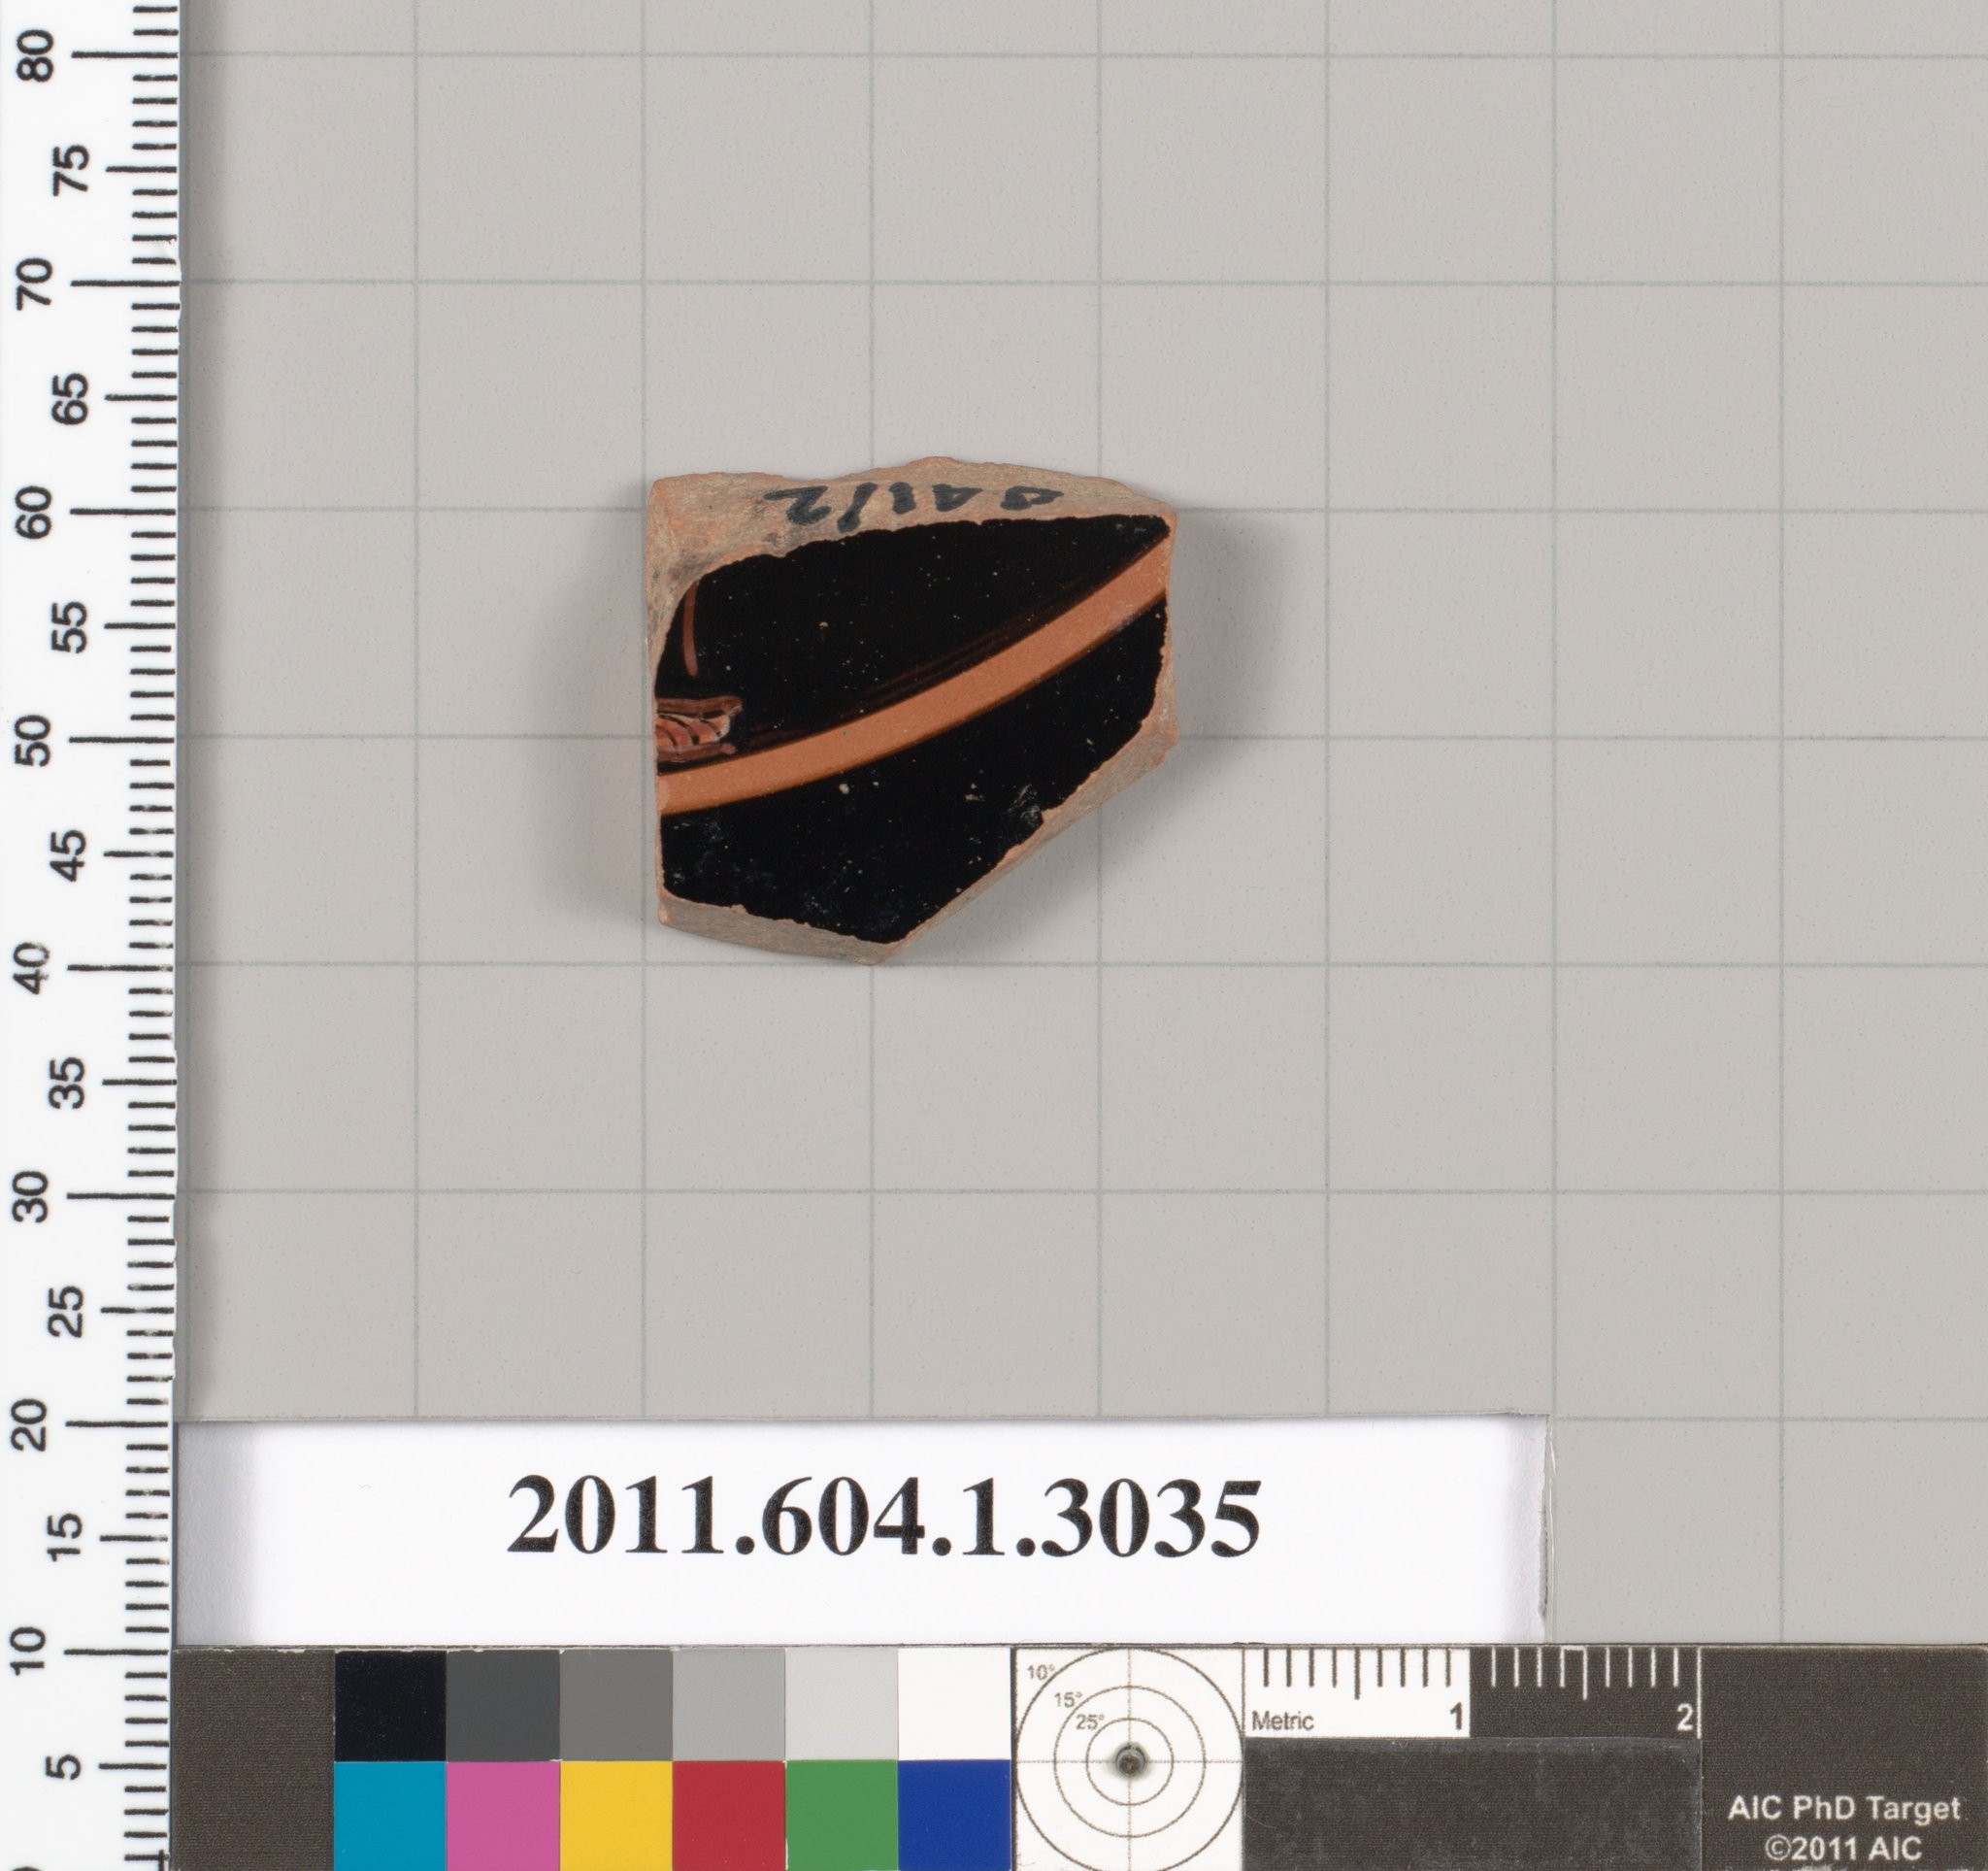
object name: kylix fragment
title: Terracotta fragment of a kylix (drinking cup)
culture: greek, attic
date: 475-451 BCE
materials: terracotta